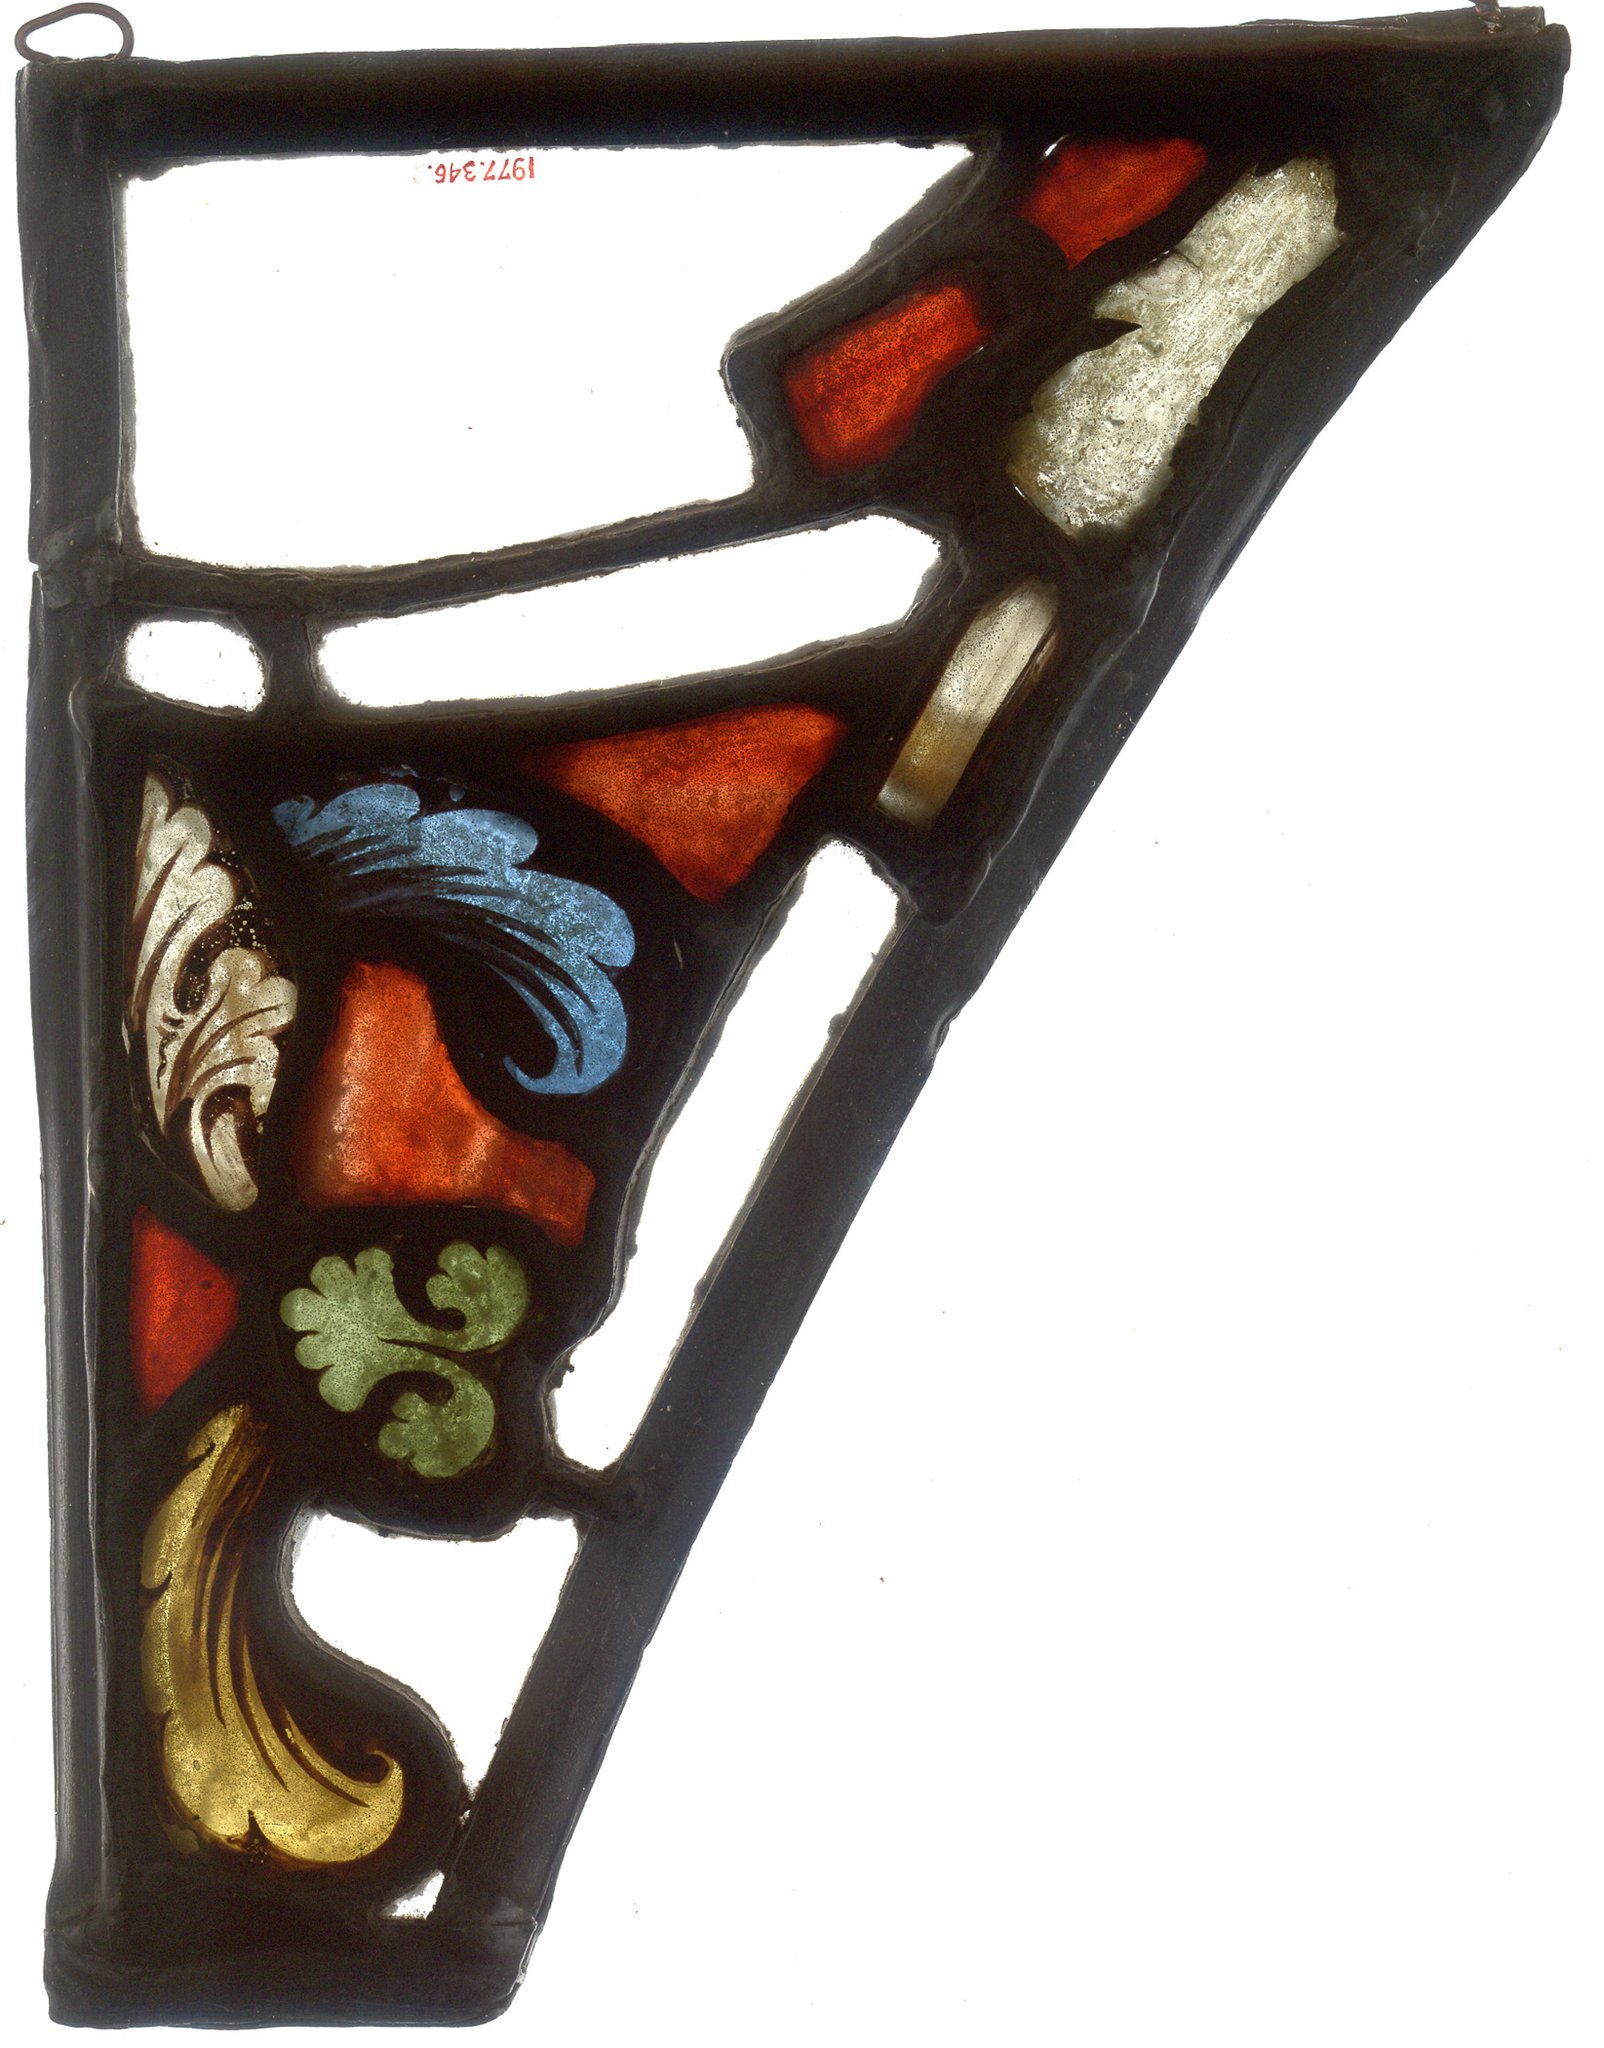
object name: fragment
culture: french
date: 1200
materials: glass, lead, metal, paint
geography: france